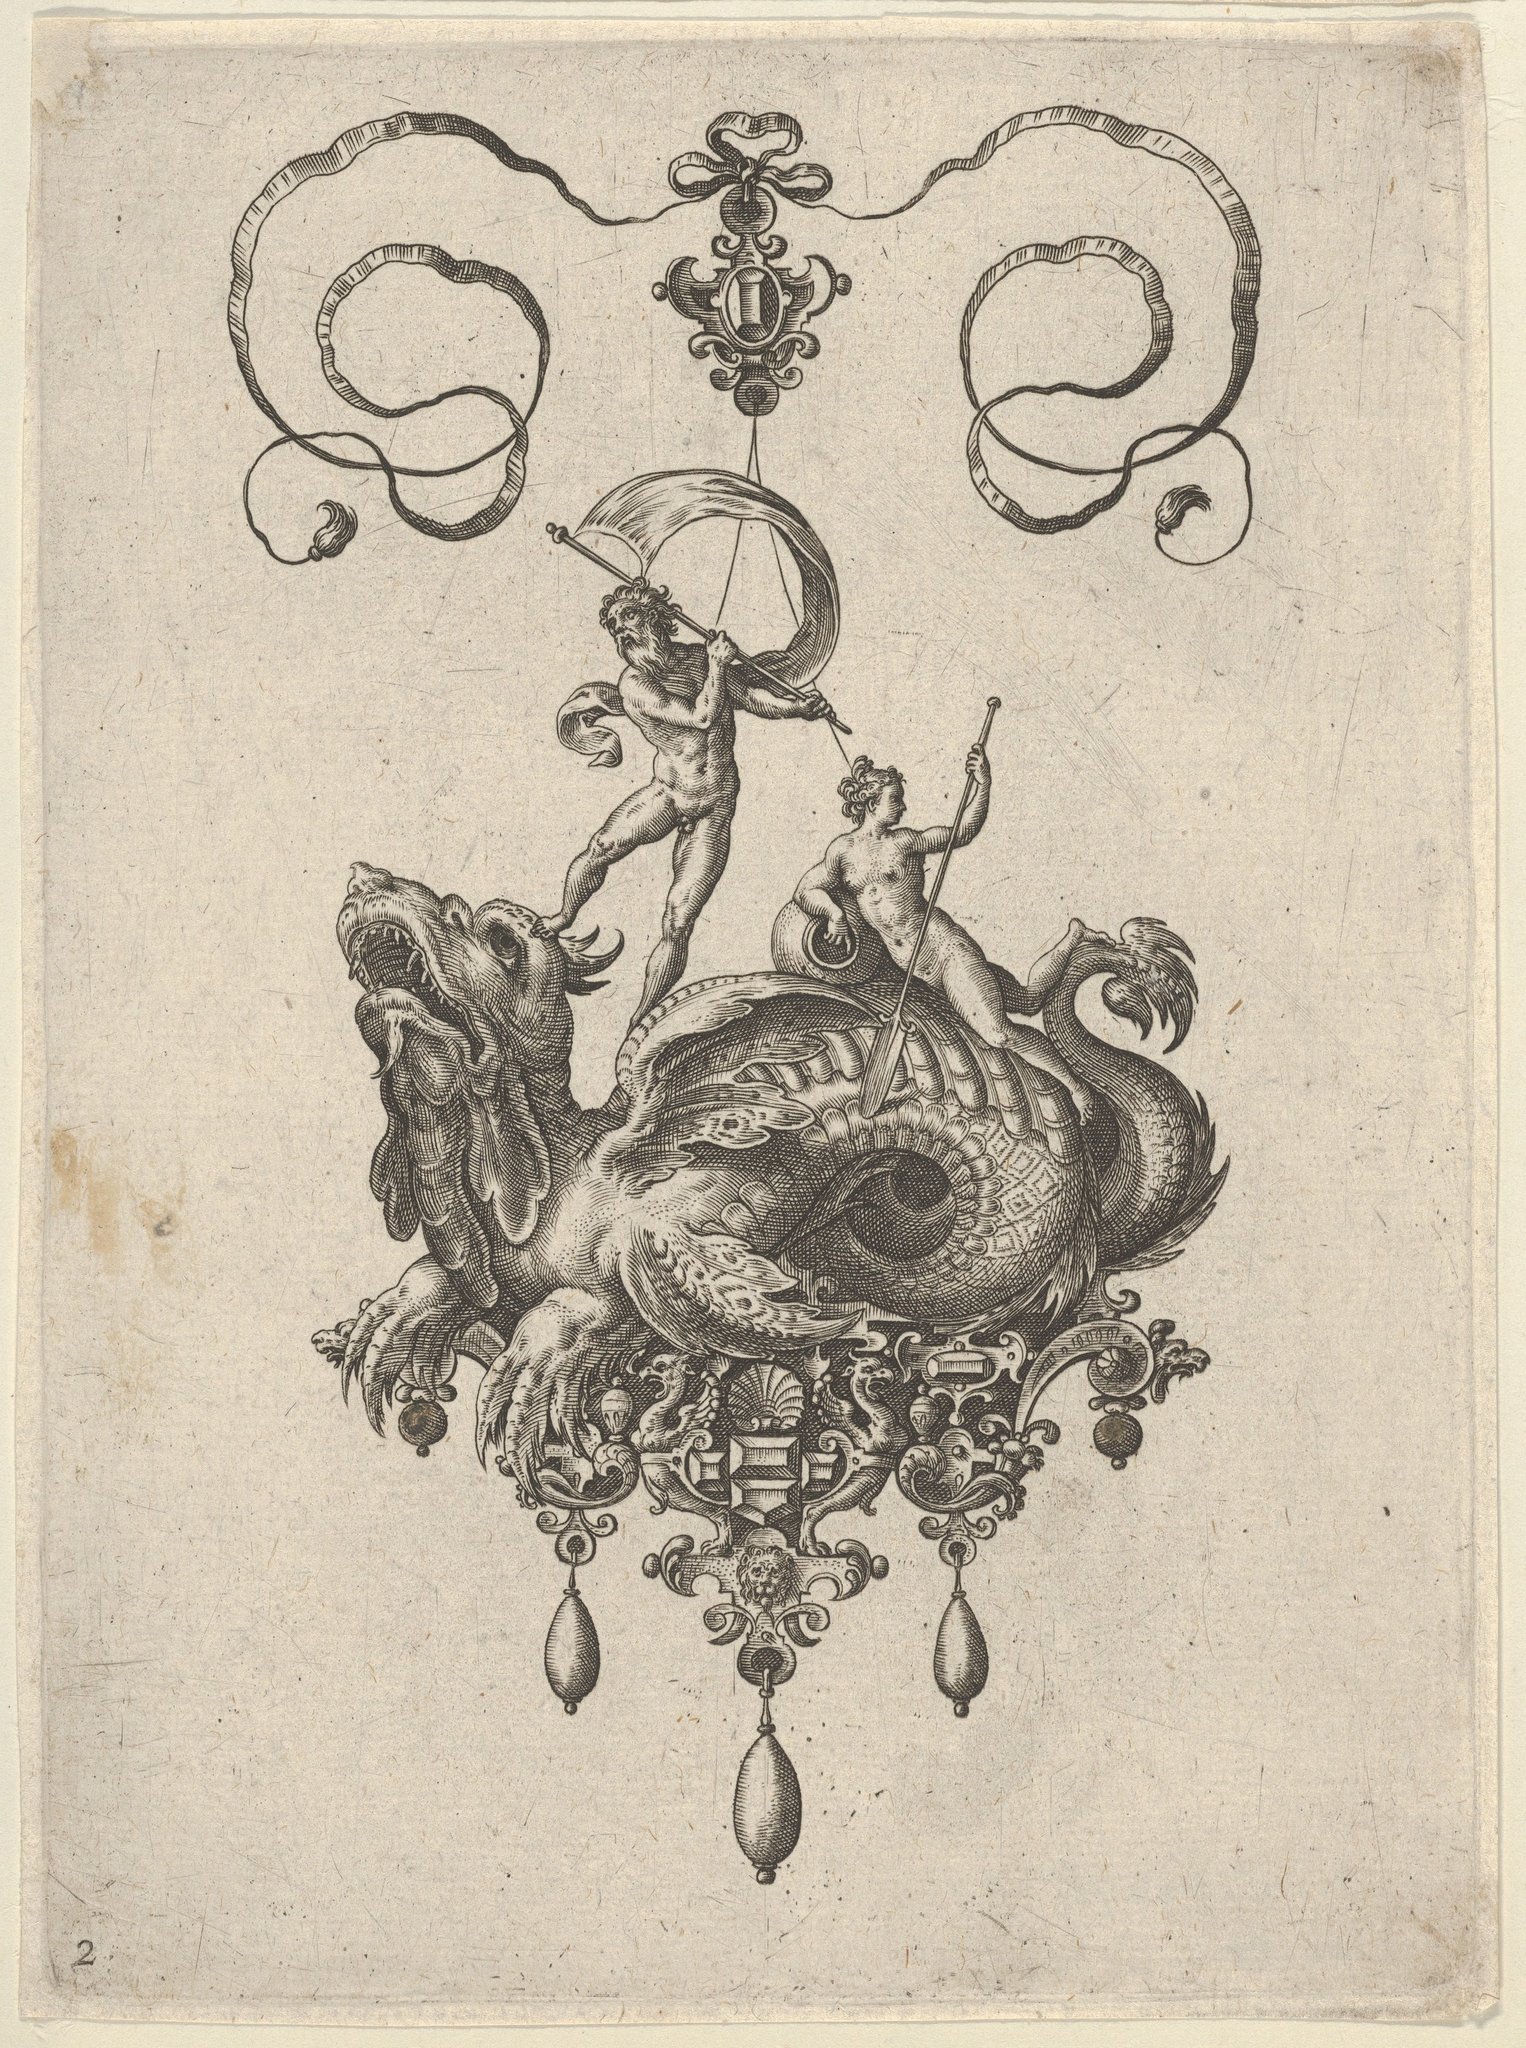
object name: print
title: Pendant Design with a Sea Monster Ridden by Thetis and a Man with a Sail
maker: adriaen collaert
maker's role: artist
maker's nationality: netherlandish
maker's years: 1560-1618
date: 1582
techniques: engraving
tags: pendants,male nudes,female nudes,monsters